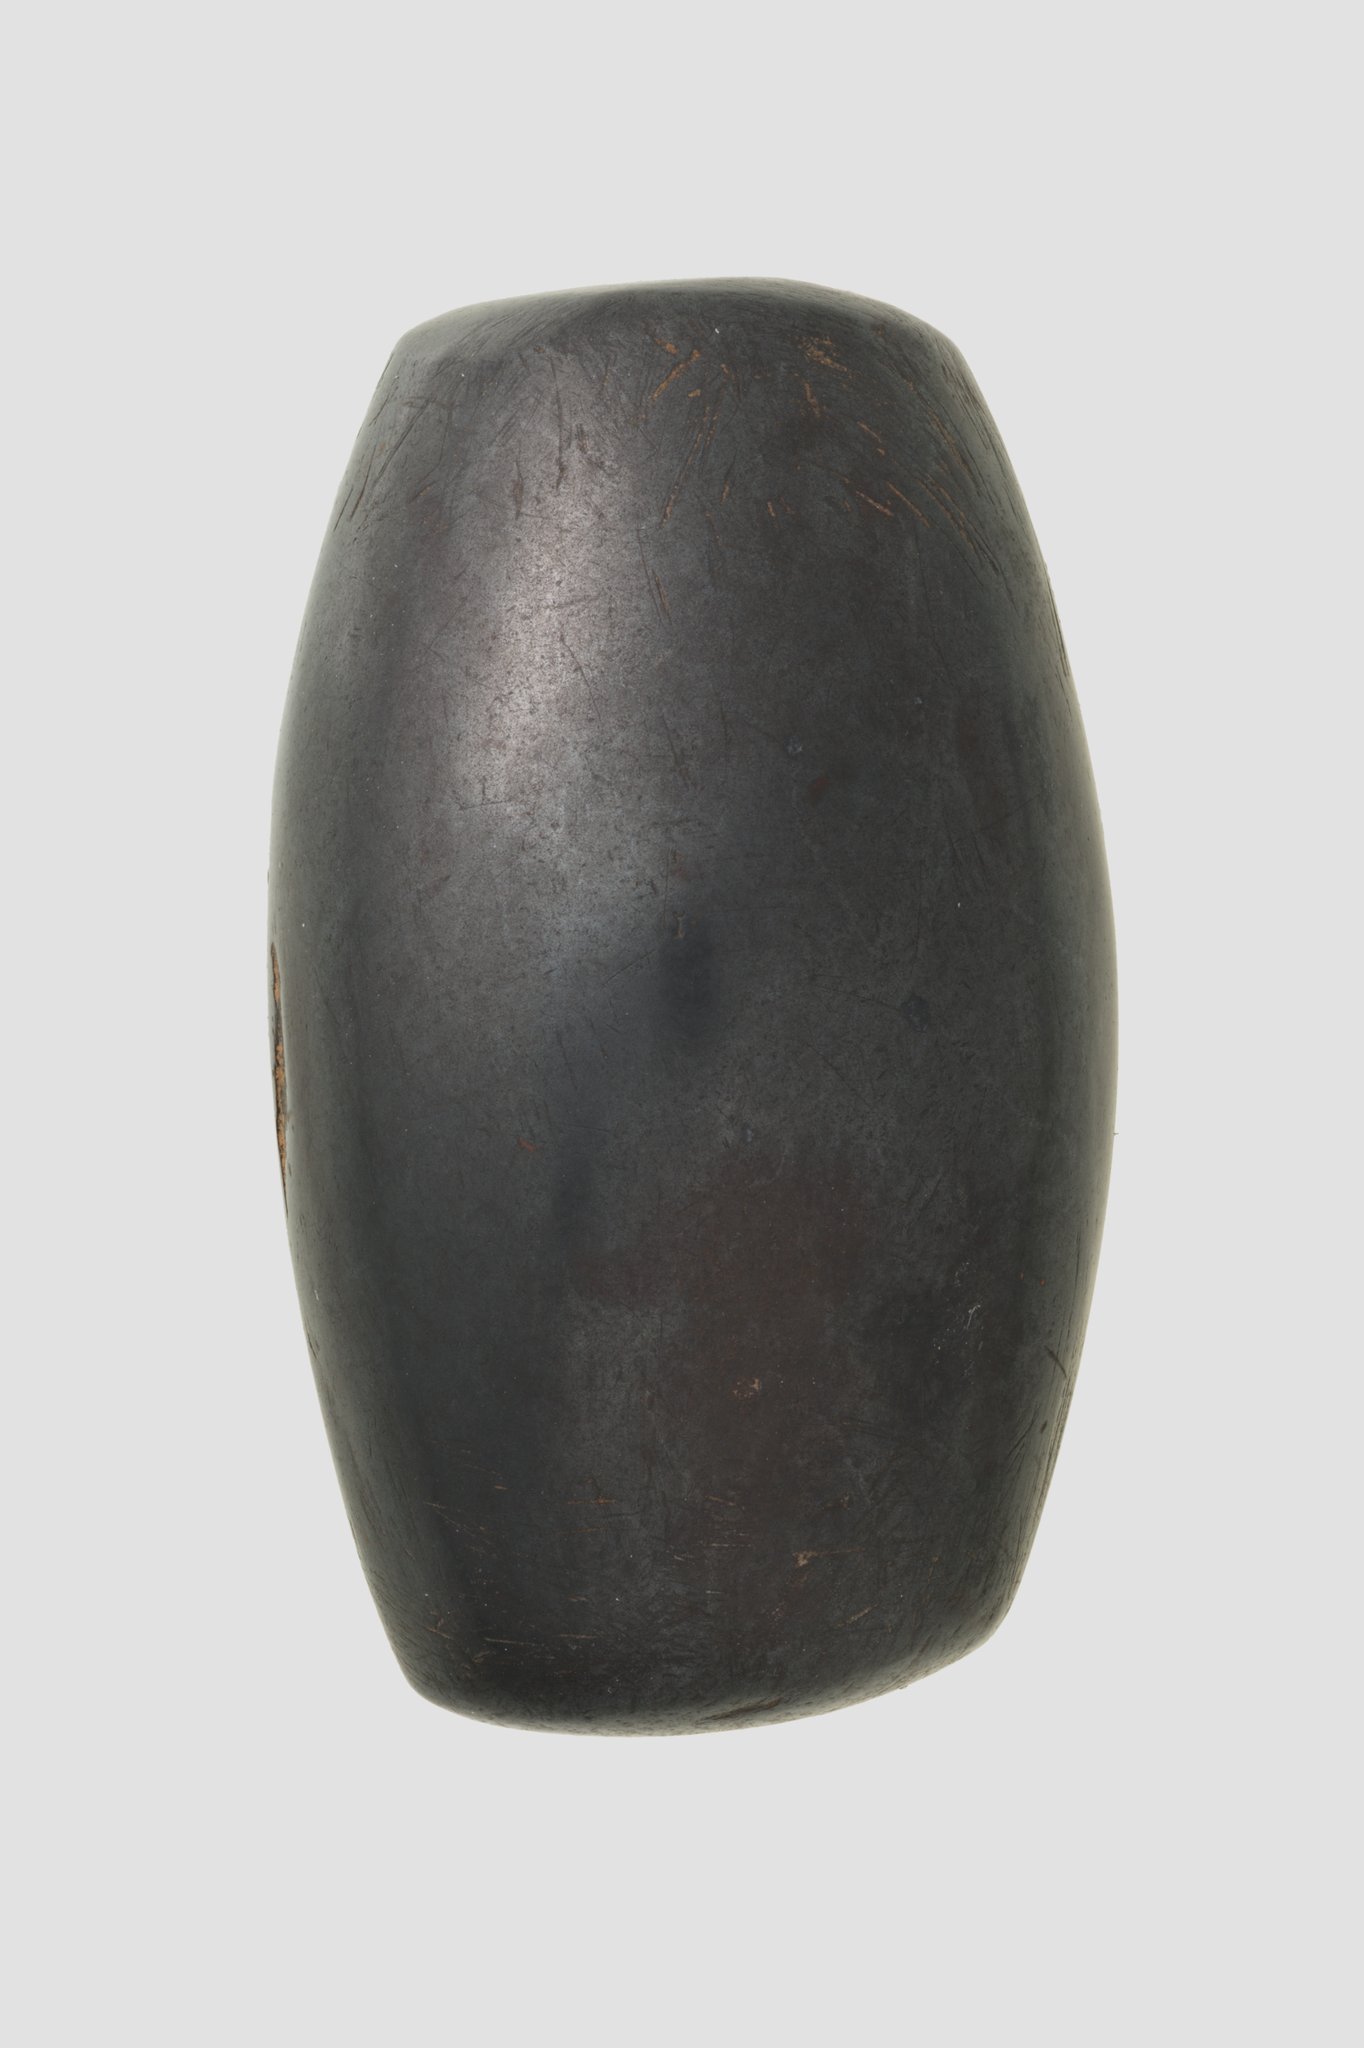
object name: weight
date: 3000-1 BCE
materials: mineral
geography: cyprus or western asia